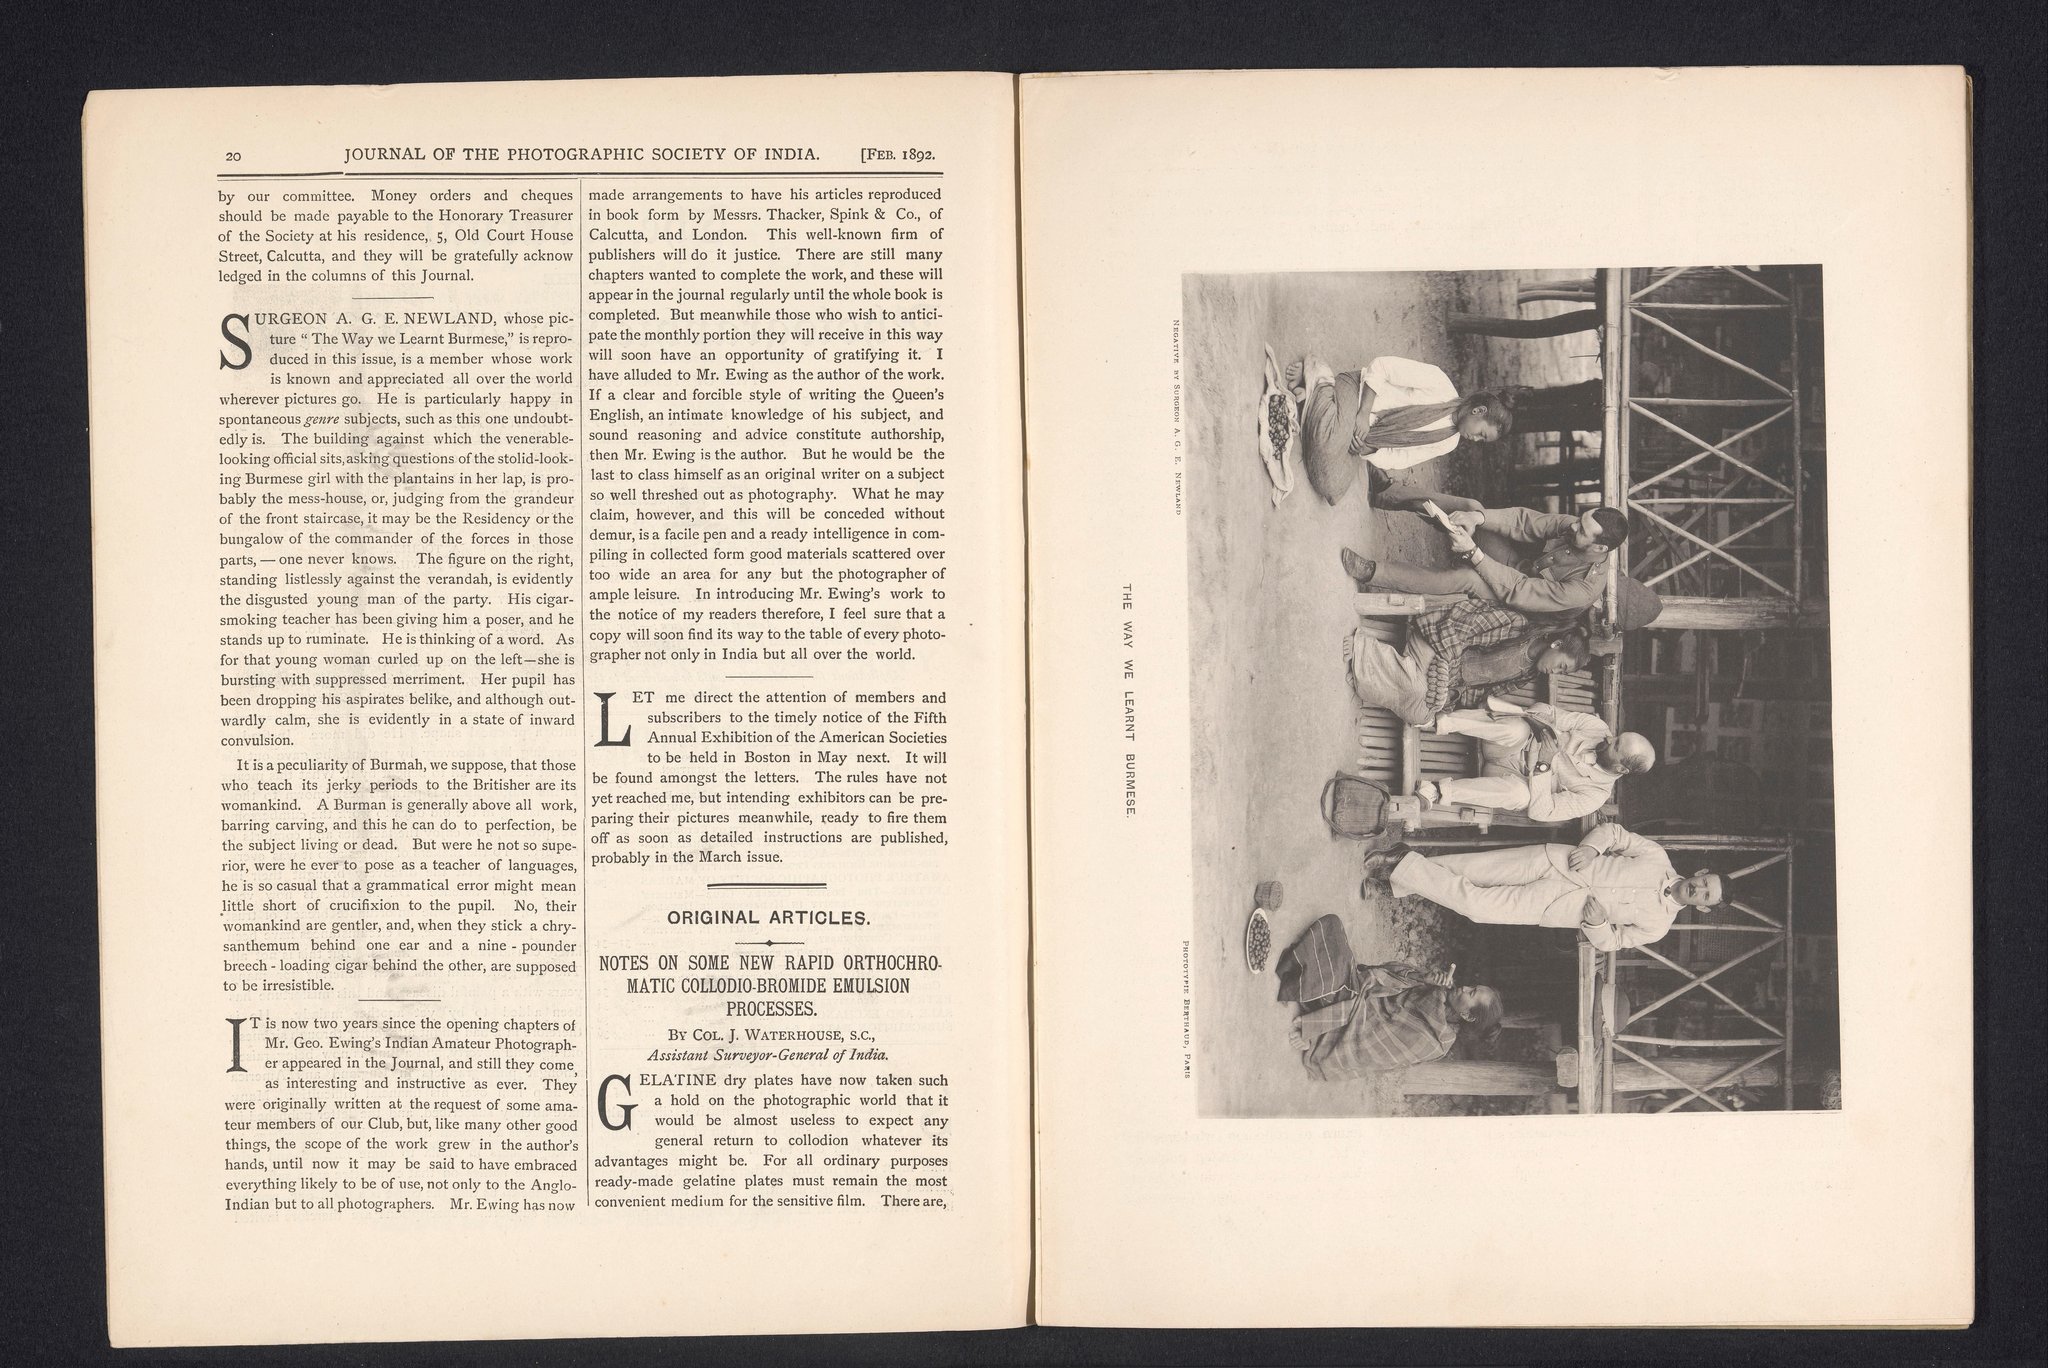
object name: page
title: The way we learnt Burmese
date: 1892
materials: paper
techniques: photograph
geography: paris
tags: book, hut, cabin, lodge